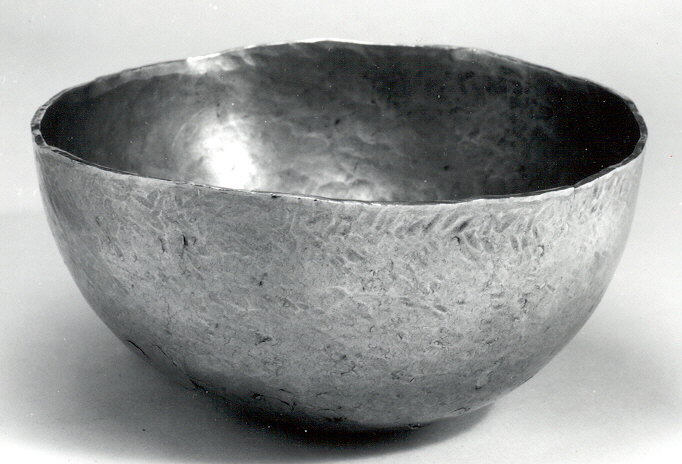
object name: bowl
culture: calima or yotoco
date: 1-700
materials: gold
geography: colombia